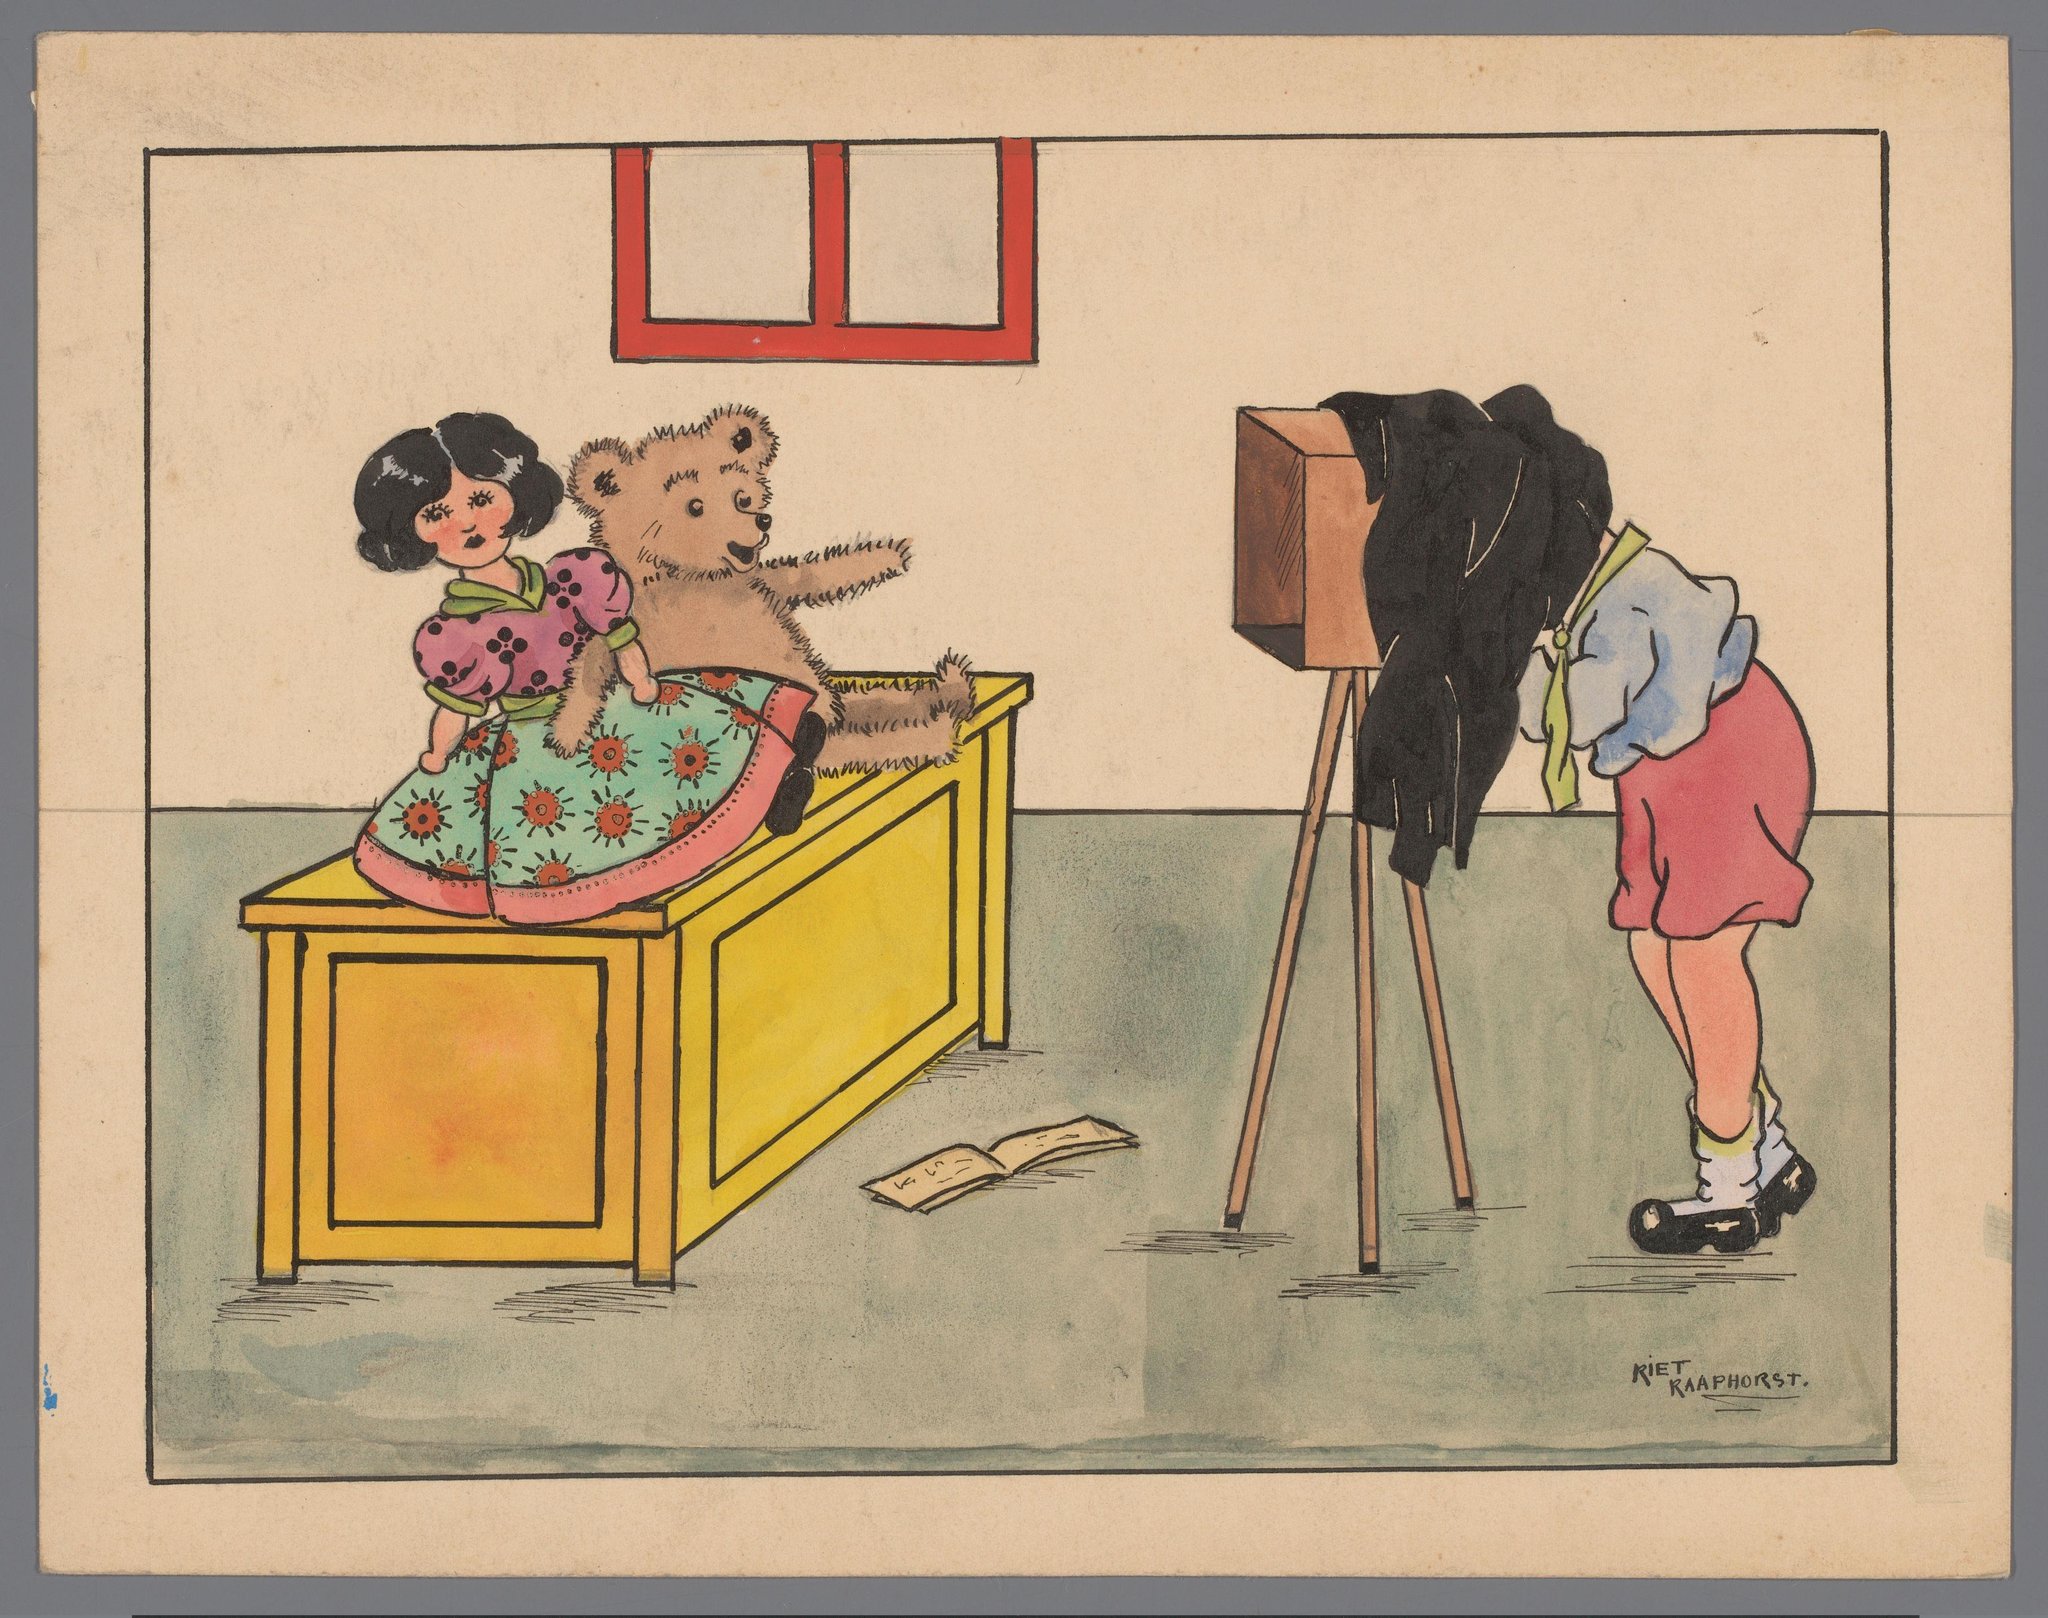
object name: photograph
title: Jongetje fotografeert zijn beer en pop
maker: riet raaphorst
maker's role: fotograaf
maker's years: 1919-1946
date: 1910-1930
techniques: pen, photography